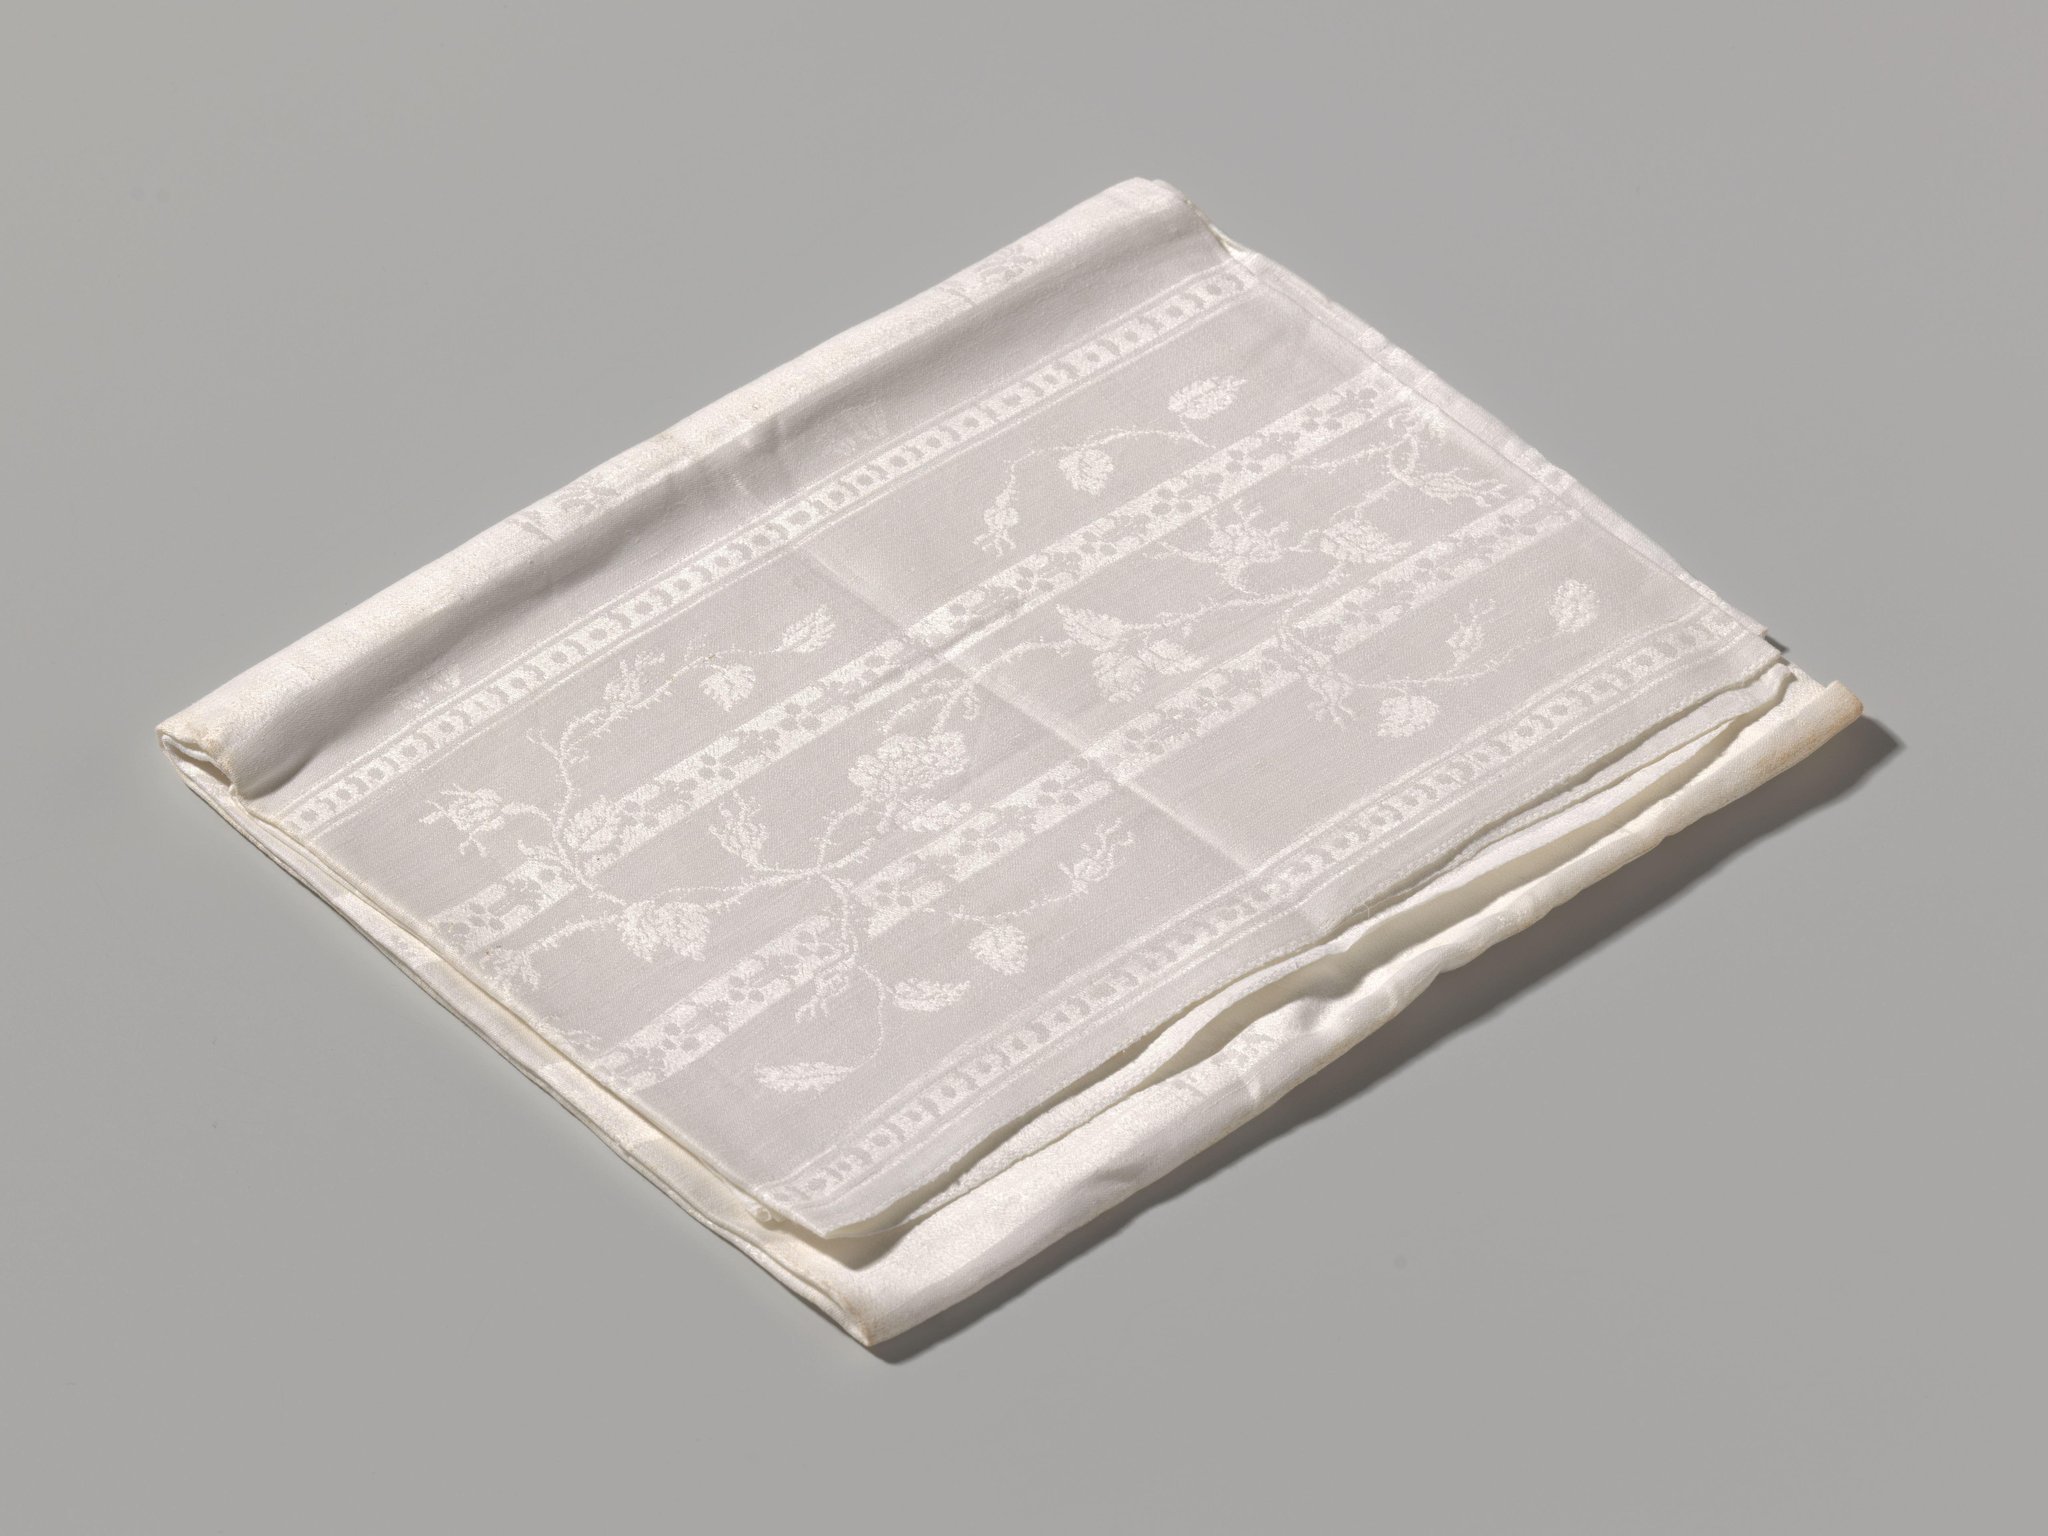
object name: napkin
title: Servet met patroon van met bloemen versierde lengtestrepen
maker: Anonymous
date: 1825-1850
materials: linen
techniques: damask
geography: netherlands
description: Wit linnen damasten servet met bloempjes versierde lengtestrepen.